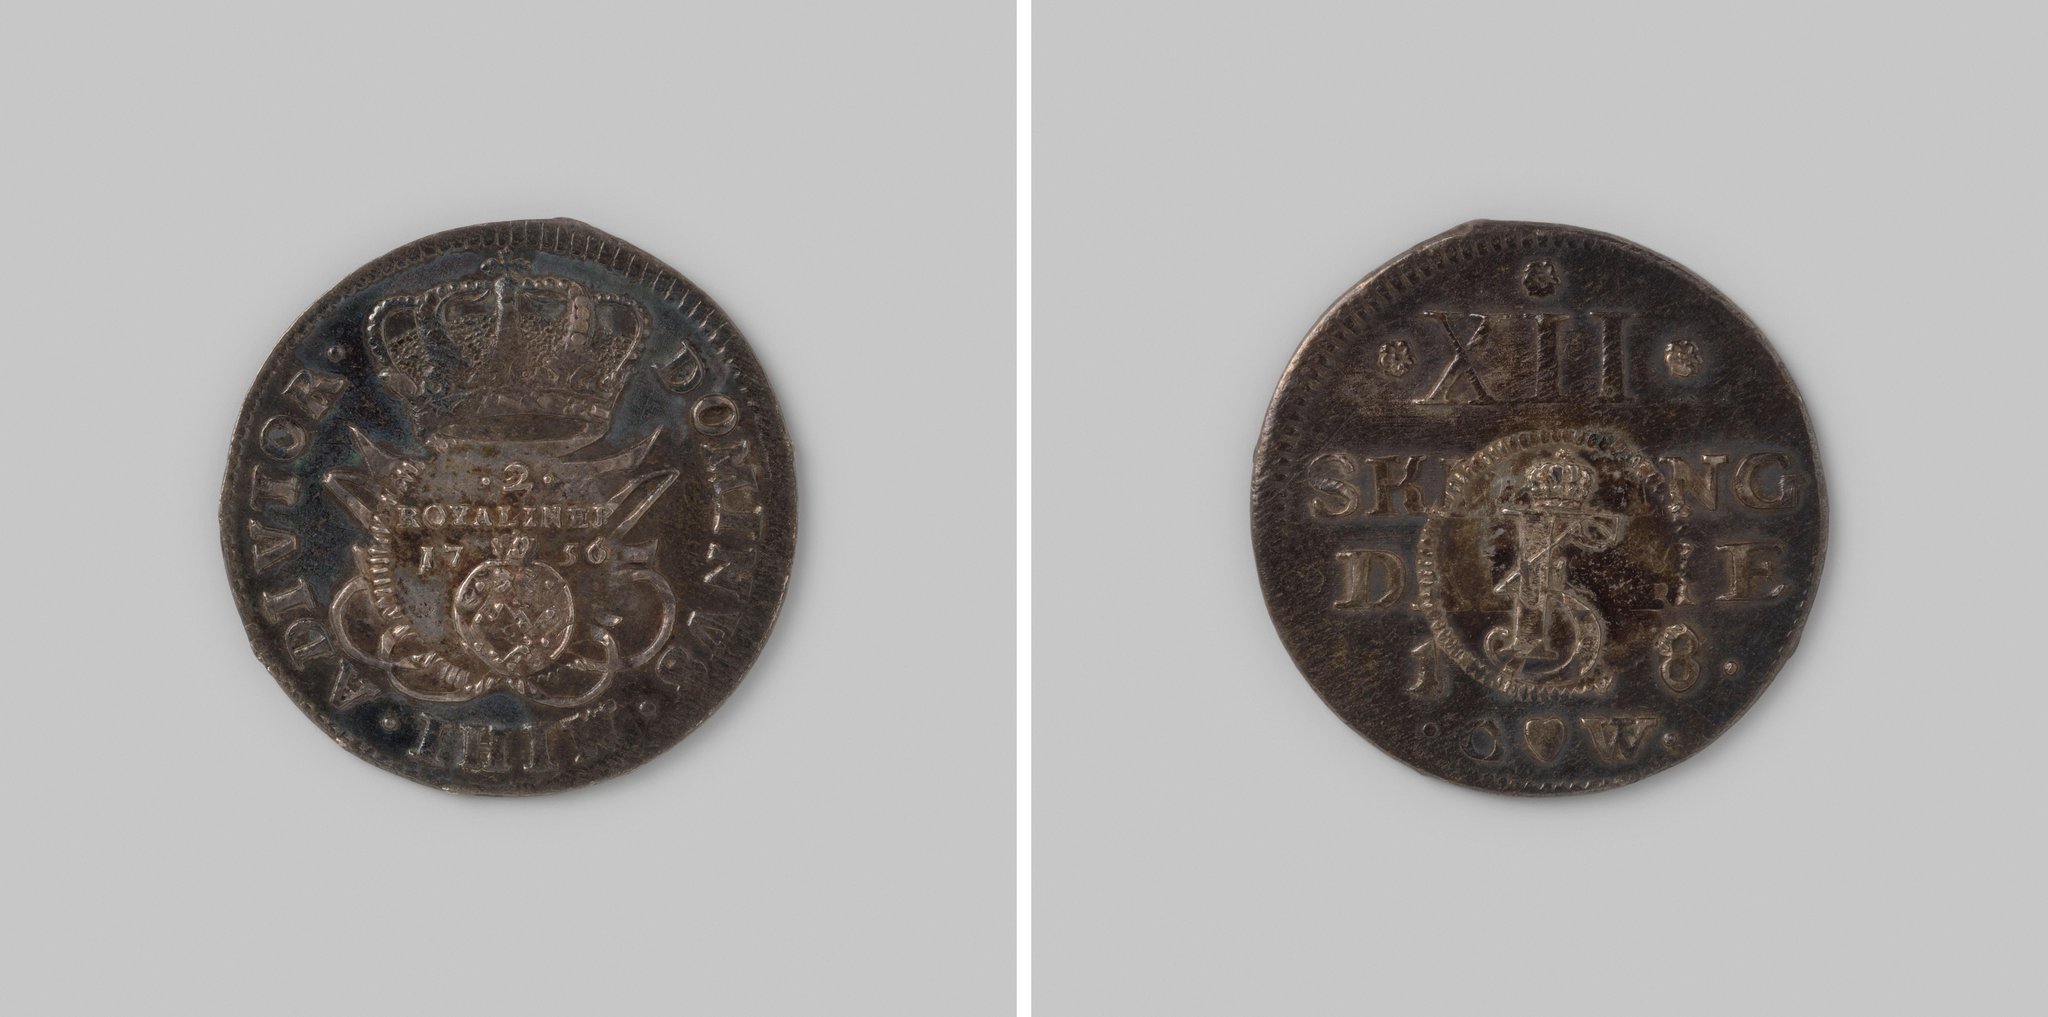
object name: coin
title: Tranquebar, Deens-India, Deense Aziatische Compagnie (DAC) op naam van koning Frederik V, 2 royaliner, 1756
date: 1756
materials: silver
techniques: striking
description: Zilveren munt. Voorzijde: gekroond monogram van de koning. Keerzijde: waarde-aanduiding: 2 royaliner in twee regels. Daaronder tussen jaartal gekroond ovaal Deens wapenschild. Proefmunt, gelagen op muntplaatje van een XII skilling Danske uit 1718.